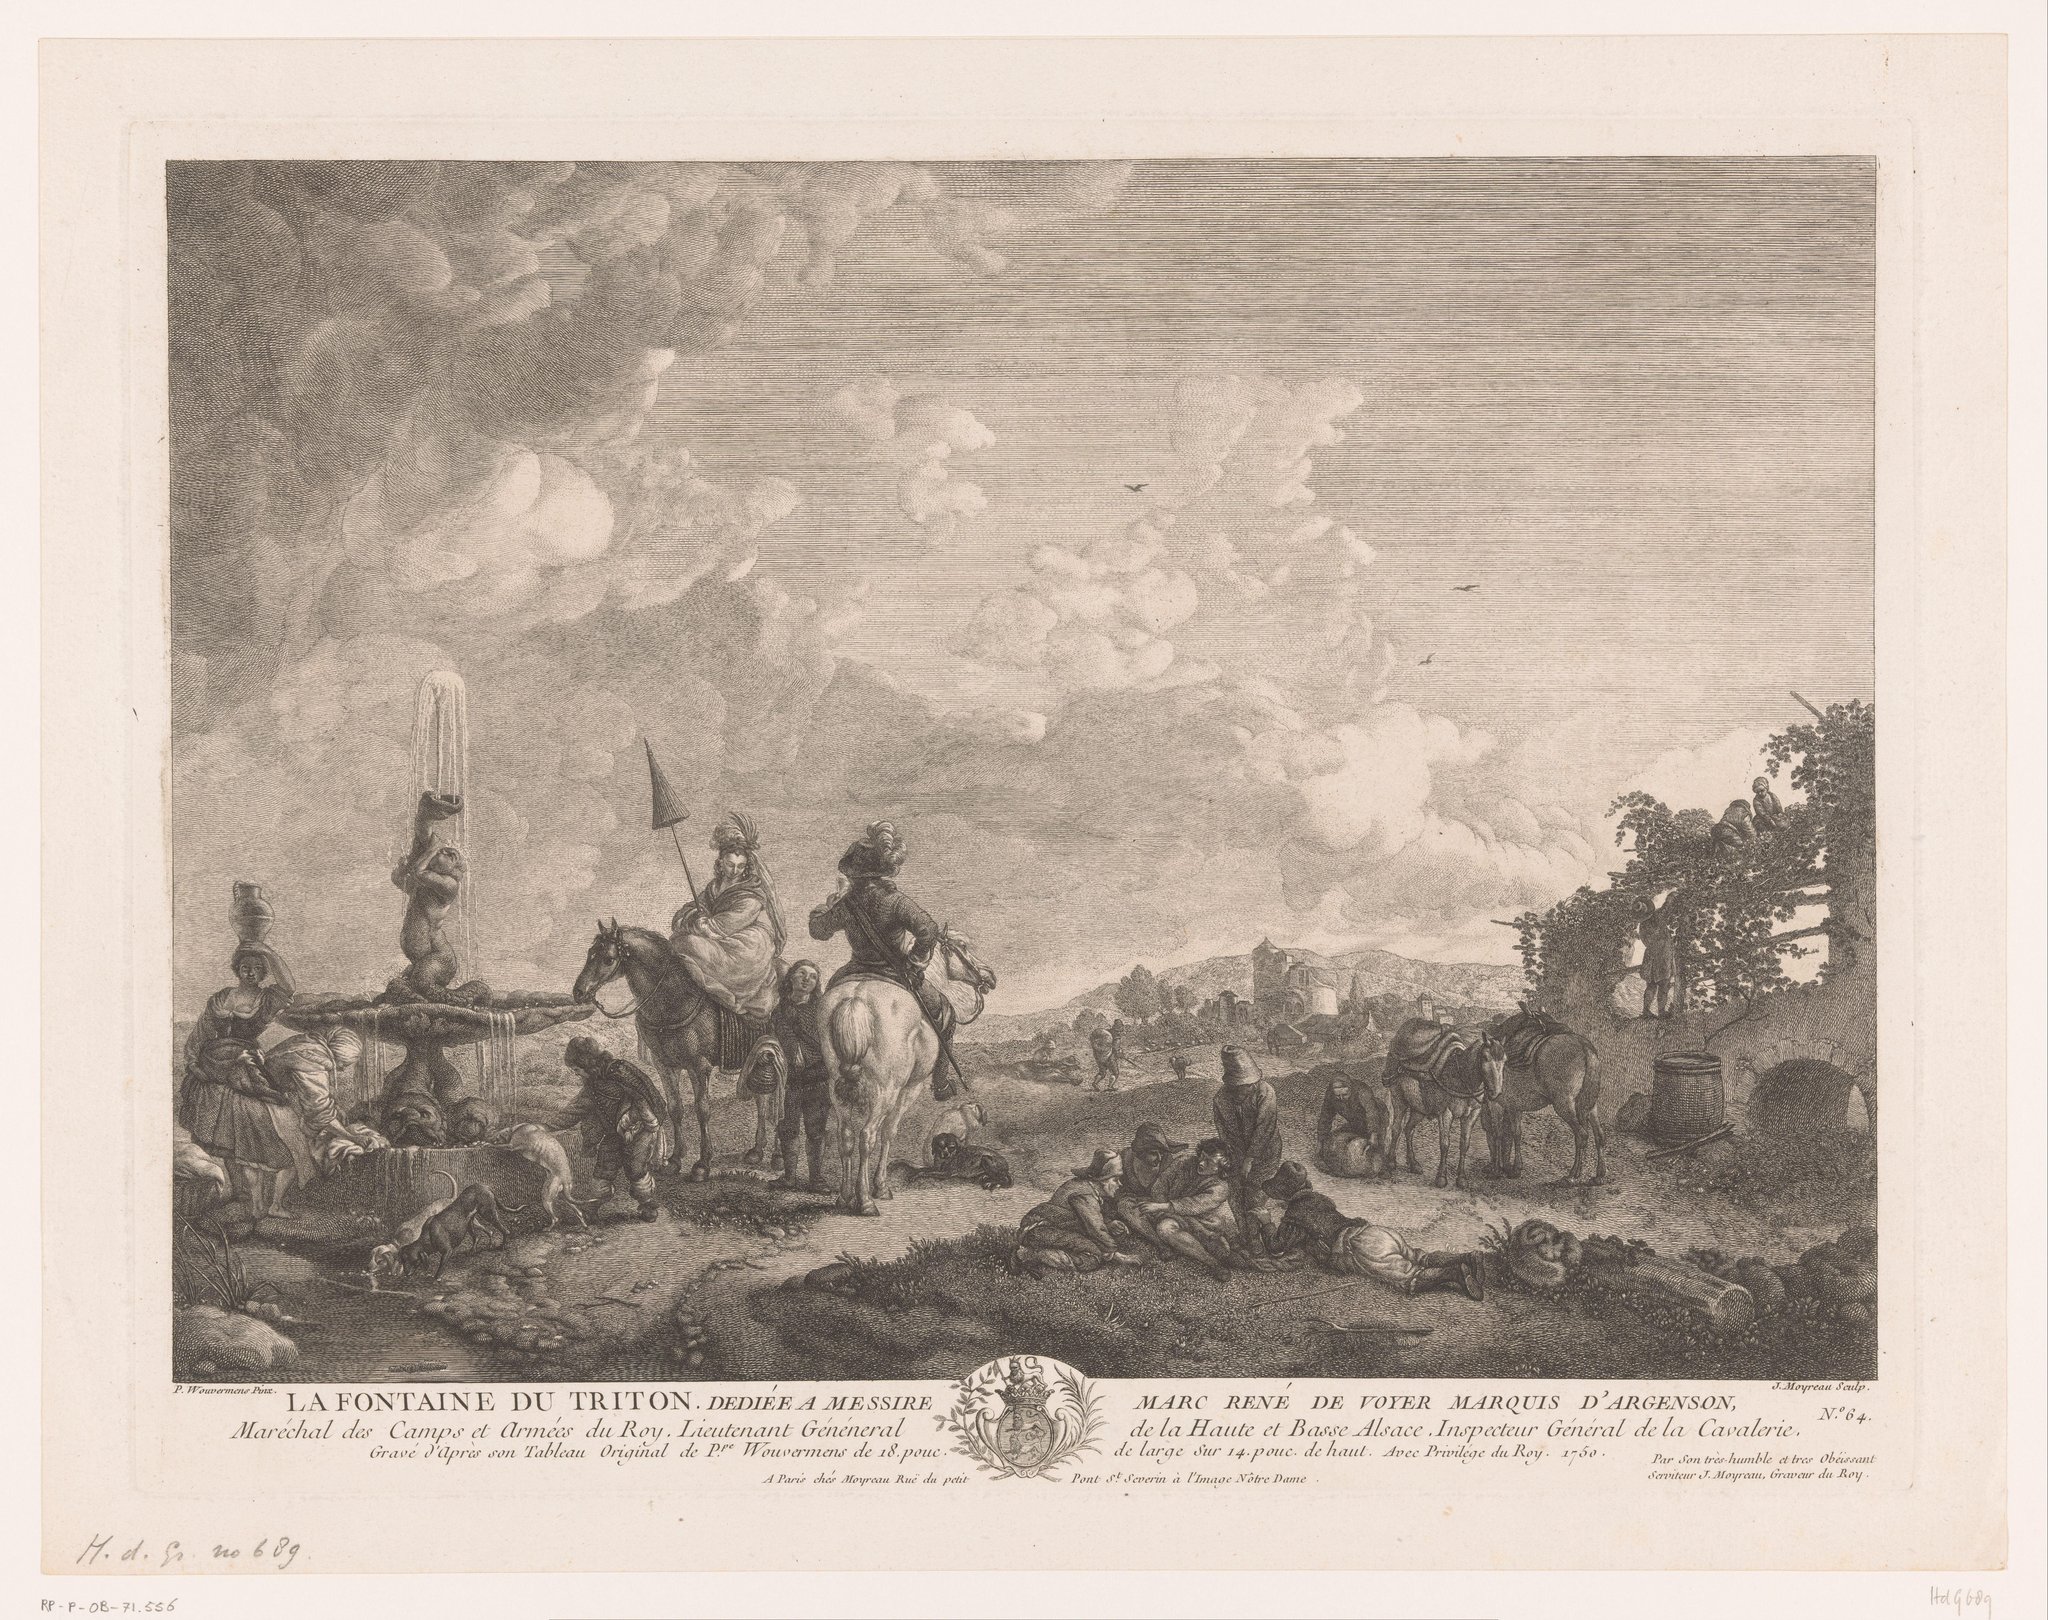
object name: print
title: La Fontaine du Triton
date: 1750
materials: paper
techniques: engraving, etching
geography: france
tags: landscapes in the temperate zone (+ landscape with figures, staffage), utilitarian, public pump or water fountain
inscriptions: collector's mark: Lugt 2228, watermark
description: Maakt deel uit van een serie van 89 prenten te dateren tussen ca. 1733-1762, naar het geschilderde oeuvre van Philips Wouwerman.